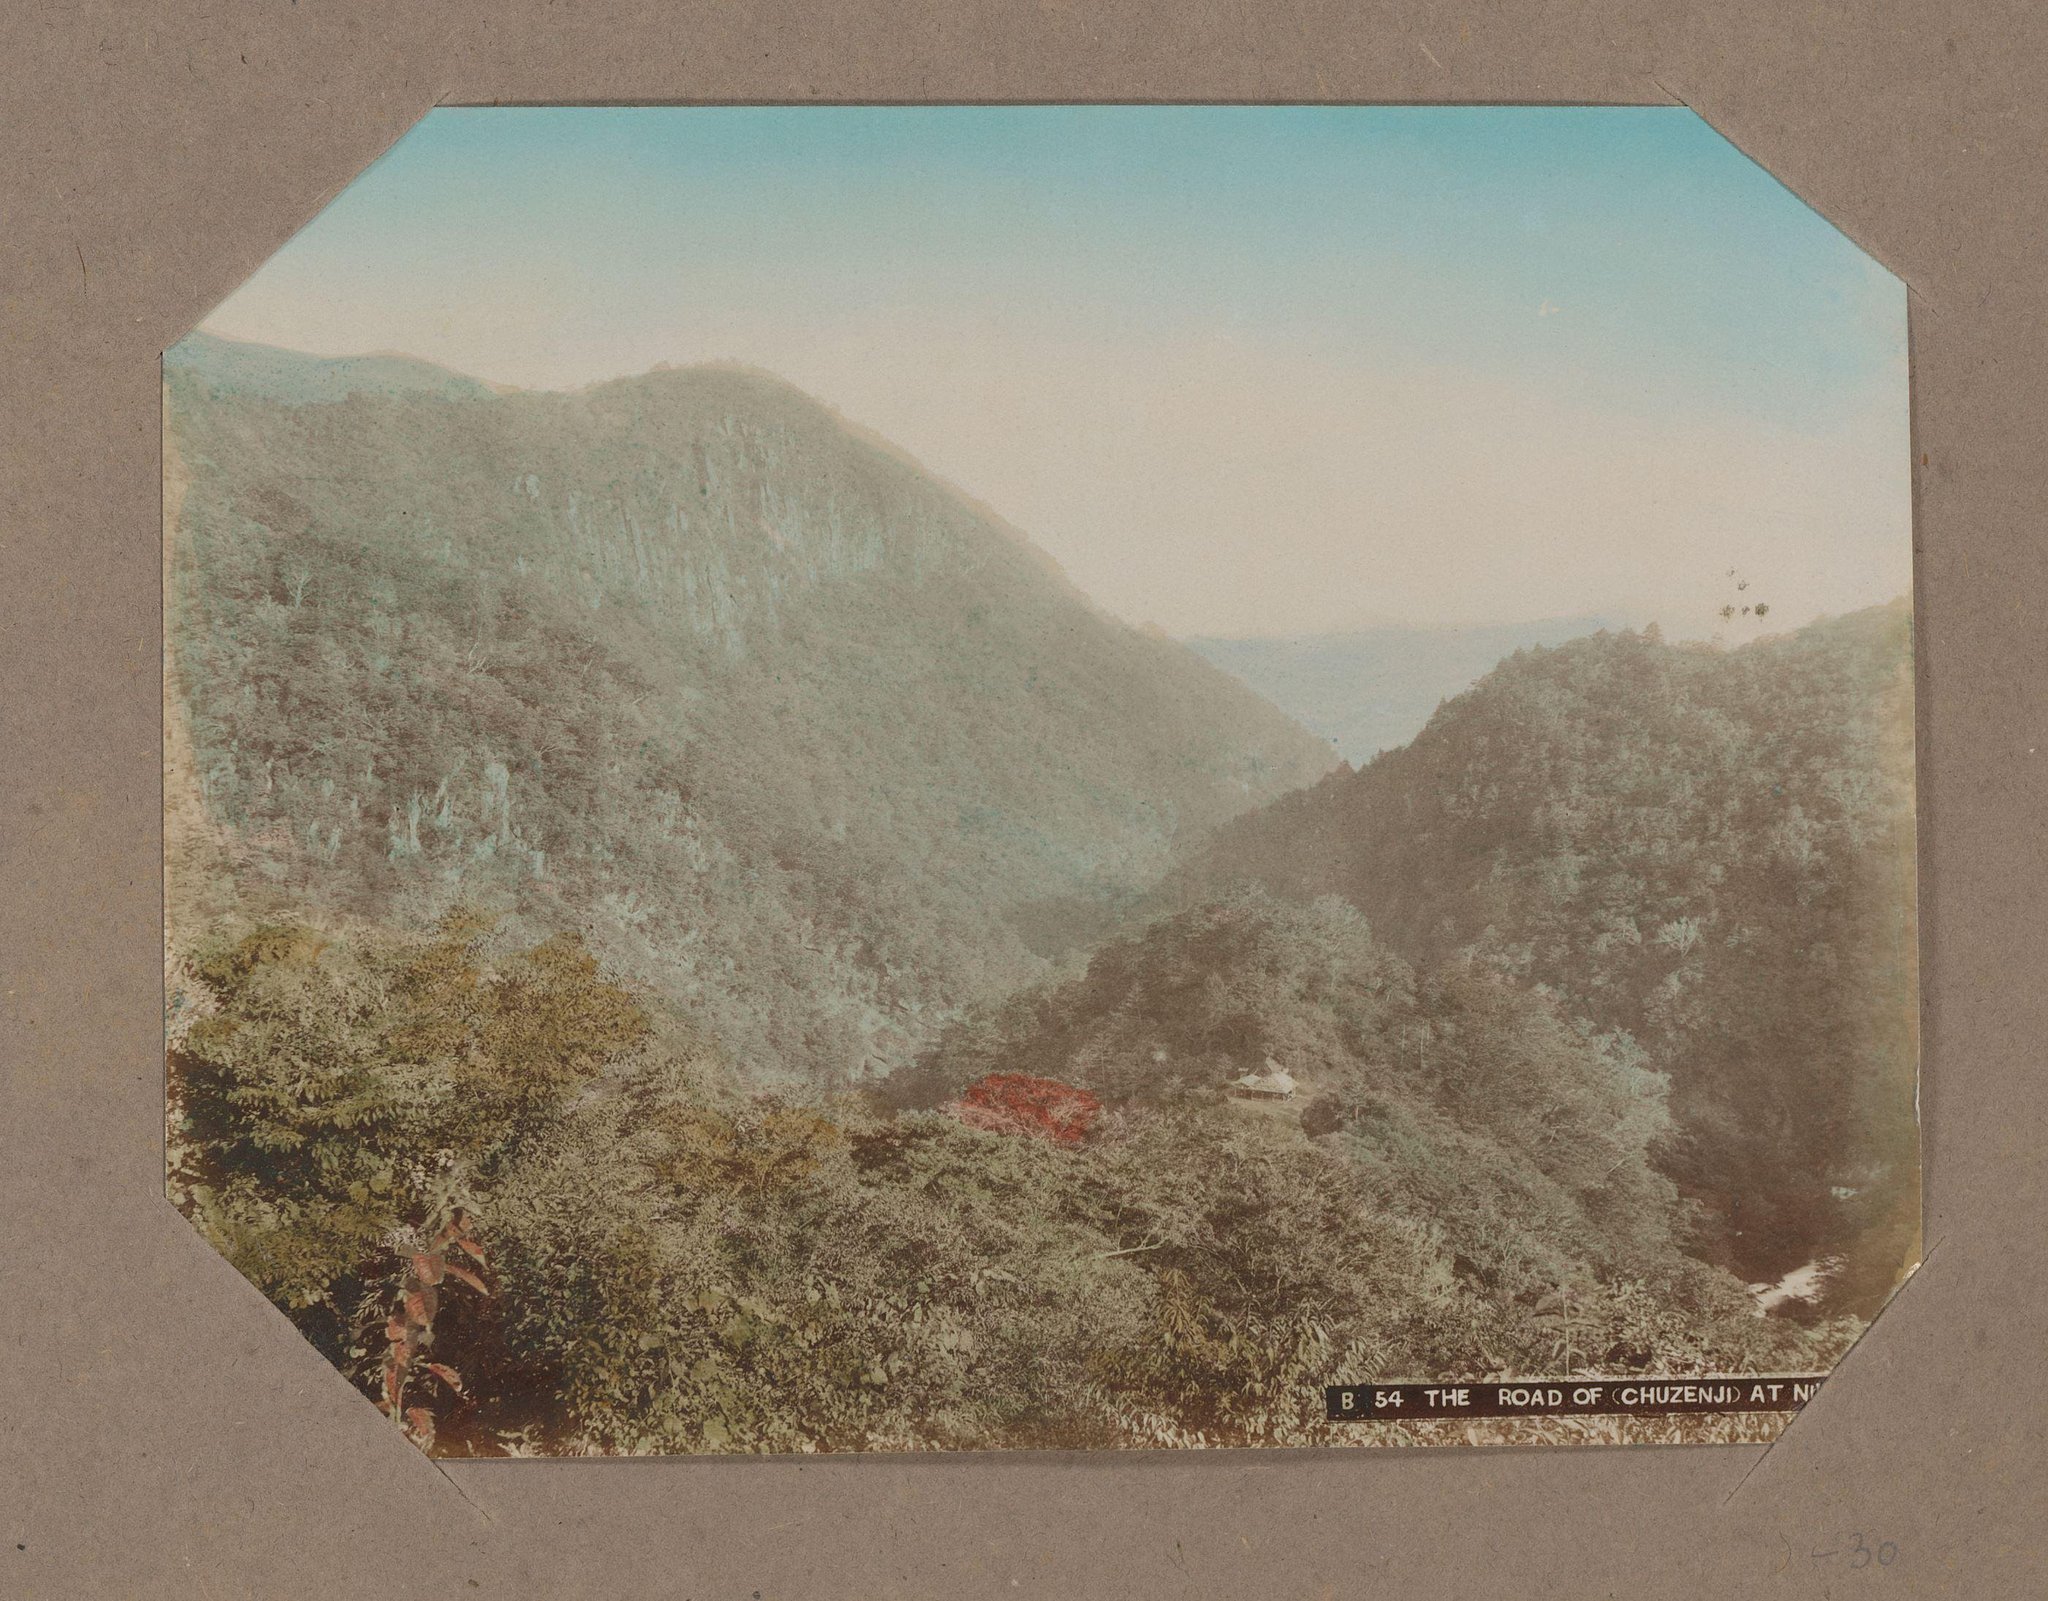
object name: album leaf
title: Landschap bij Nikko, Japan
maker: Anonymous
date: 1890-1903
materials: paper, photographic support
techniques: albumen print, hand coloring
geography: japan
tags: landscapes, mountains, japan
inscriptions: inscription: ‘B 54 The Road of (Chuzenji) at Nikko’